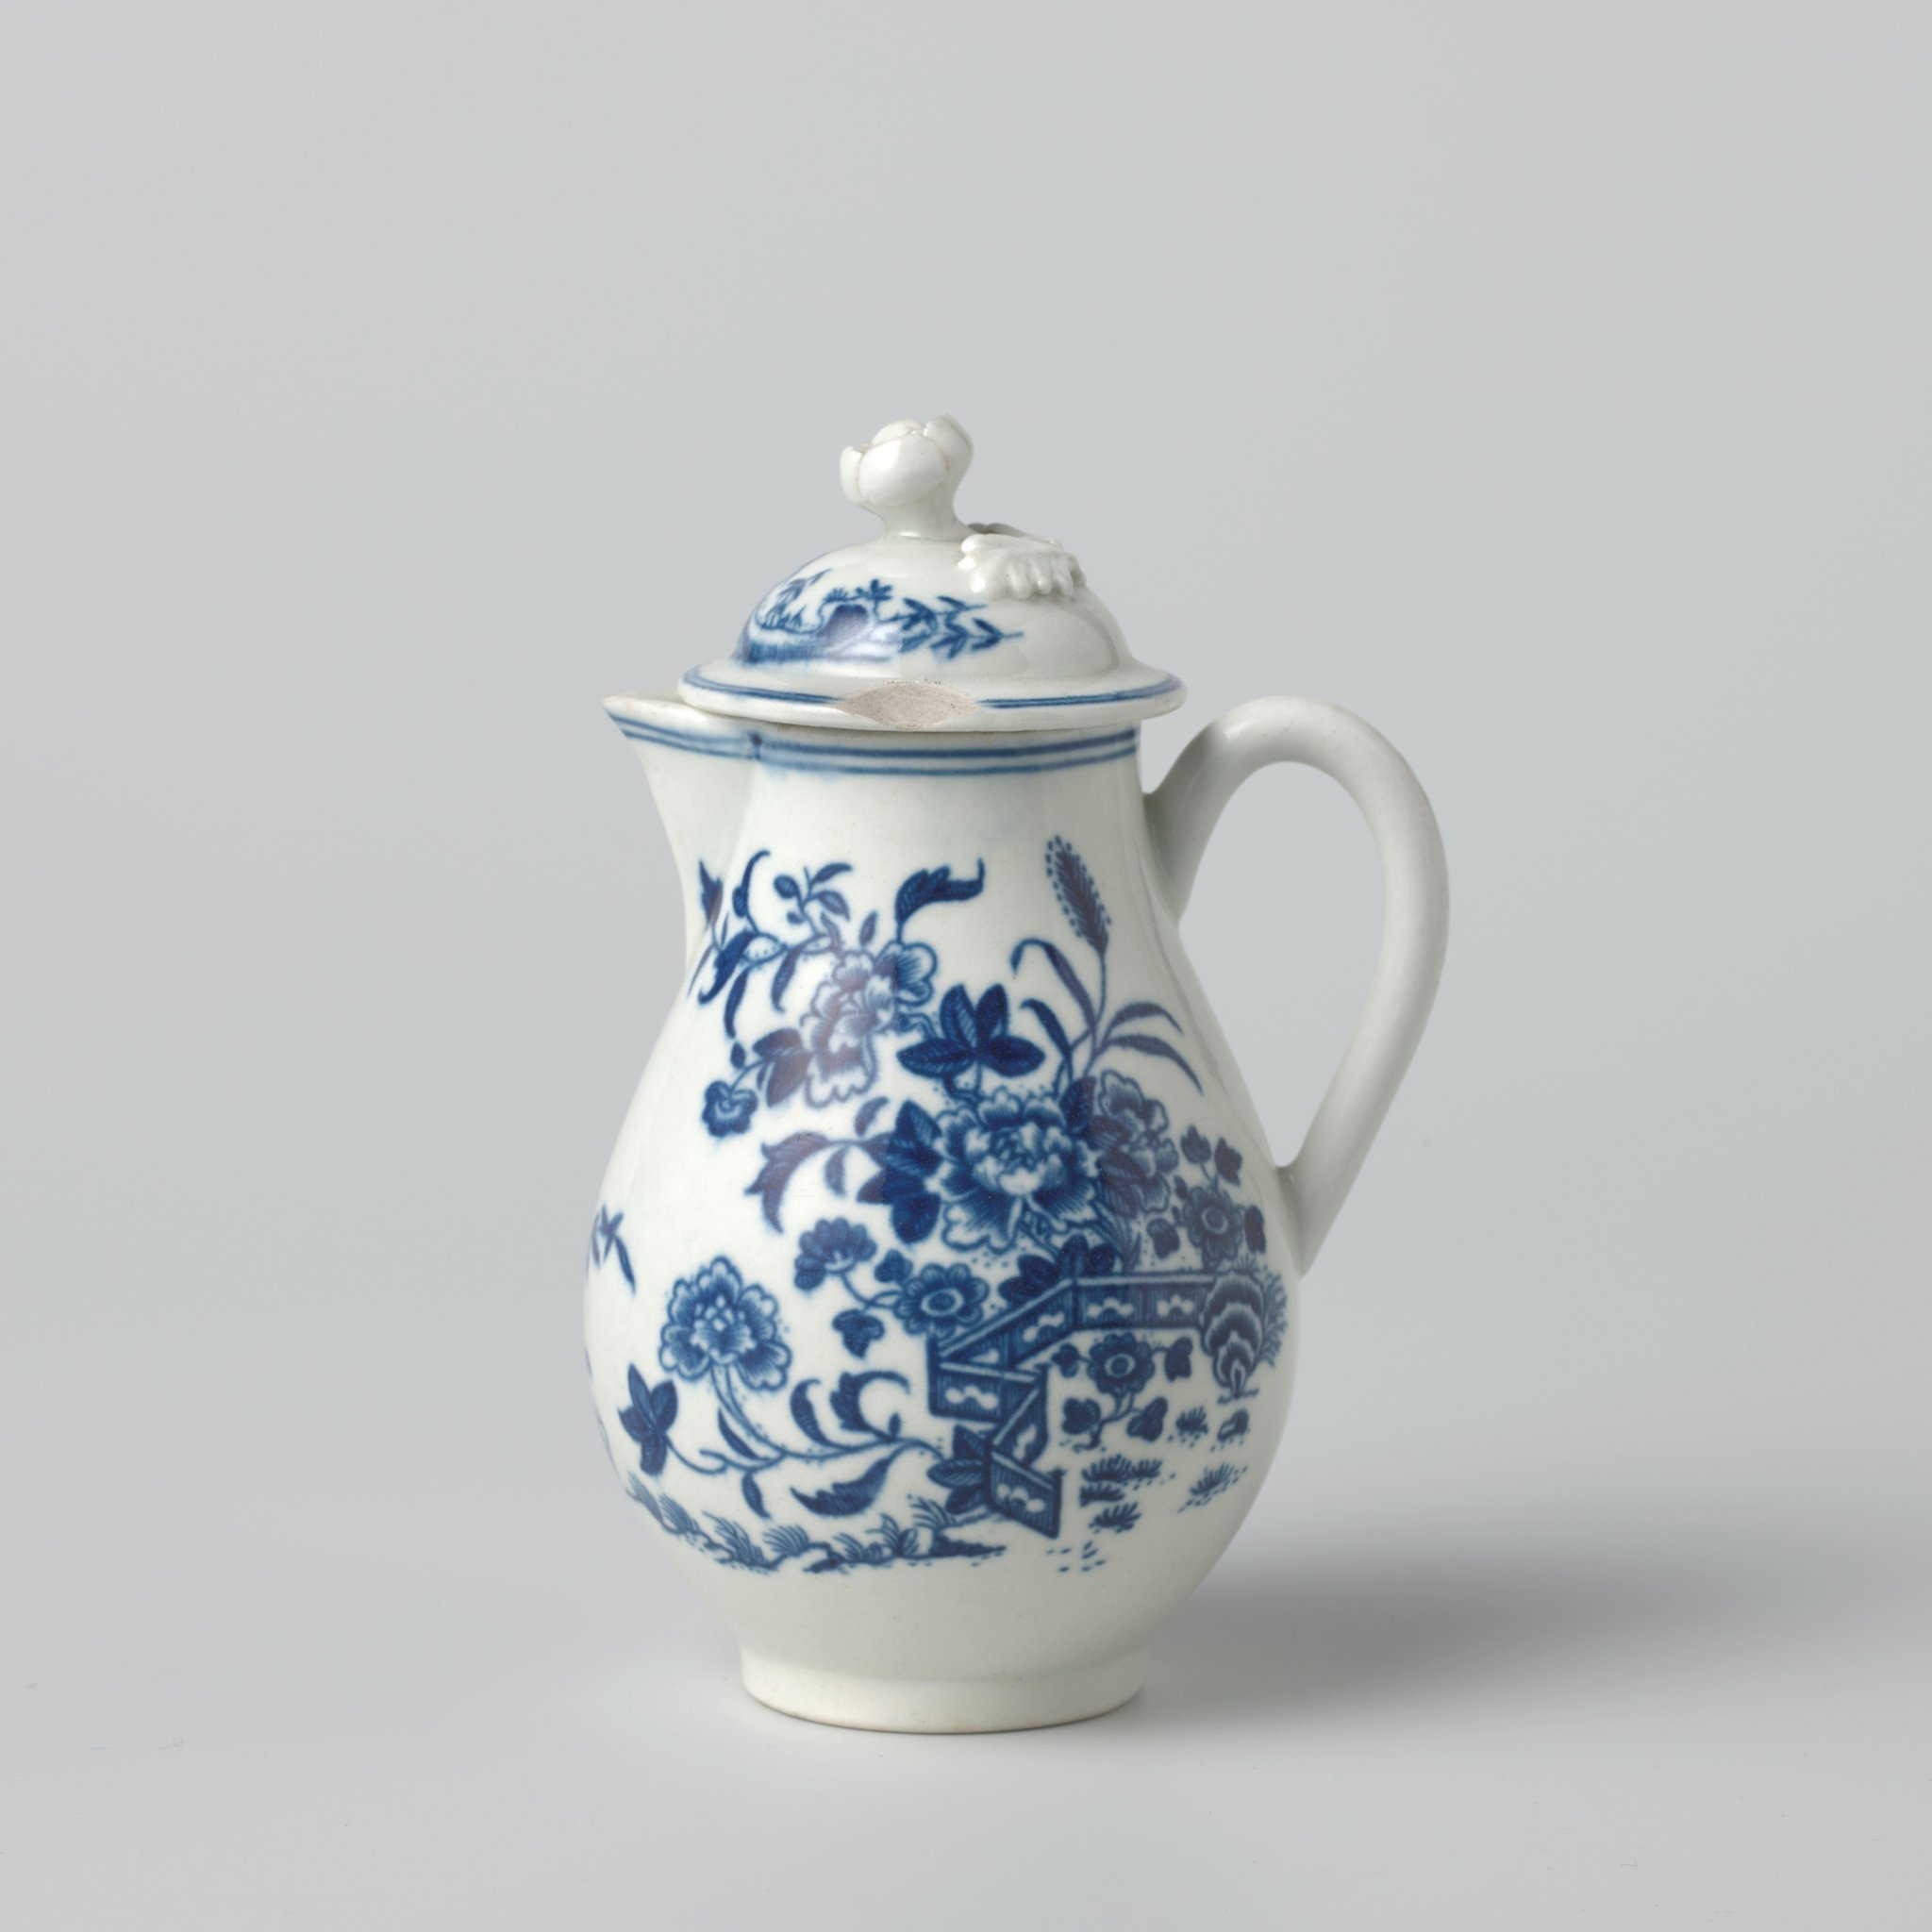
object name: lid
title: Deksel van Worcester-porselein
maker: Anonymous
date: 1800-1900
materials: porcelain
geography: worcester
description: Deksel van Worcester-porselein, het niet passende deksel vertoont eenzelfde versiering.